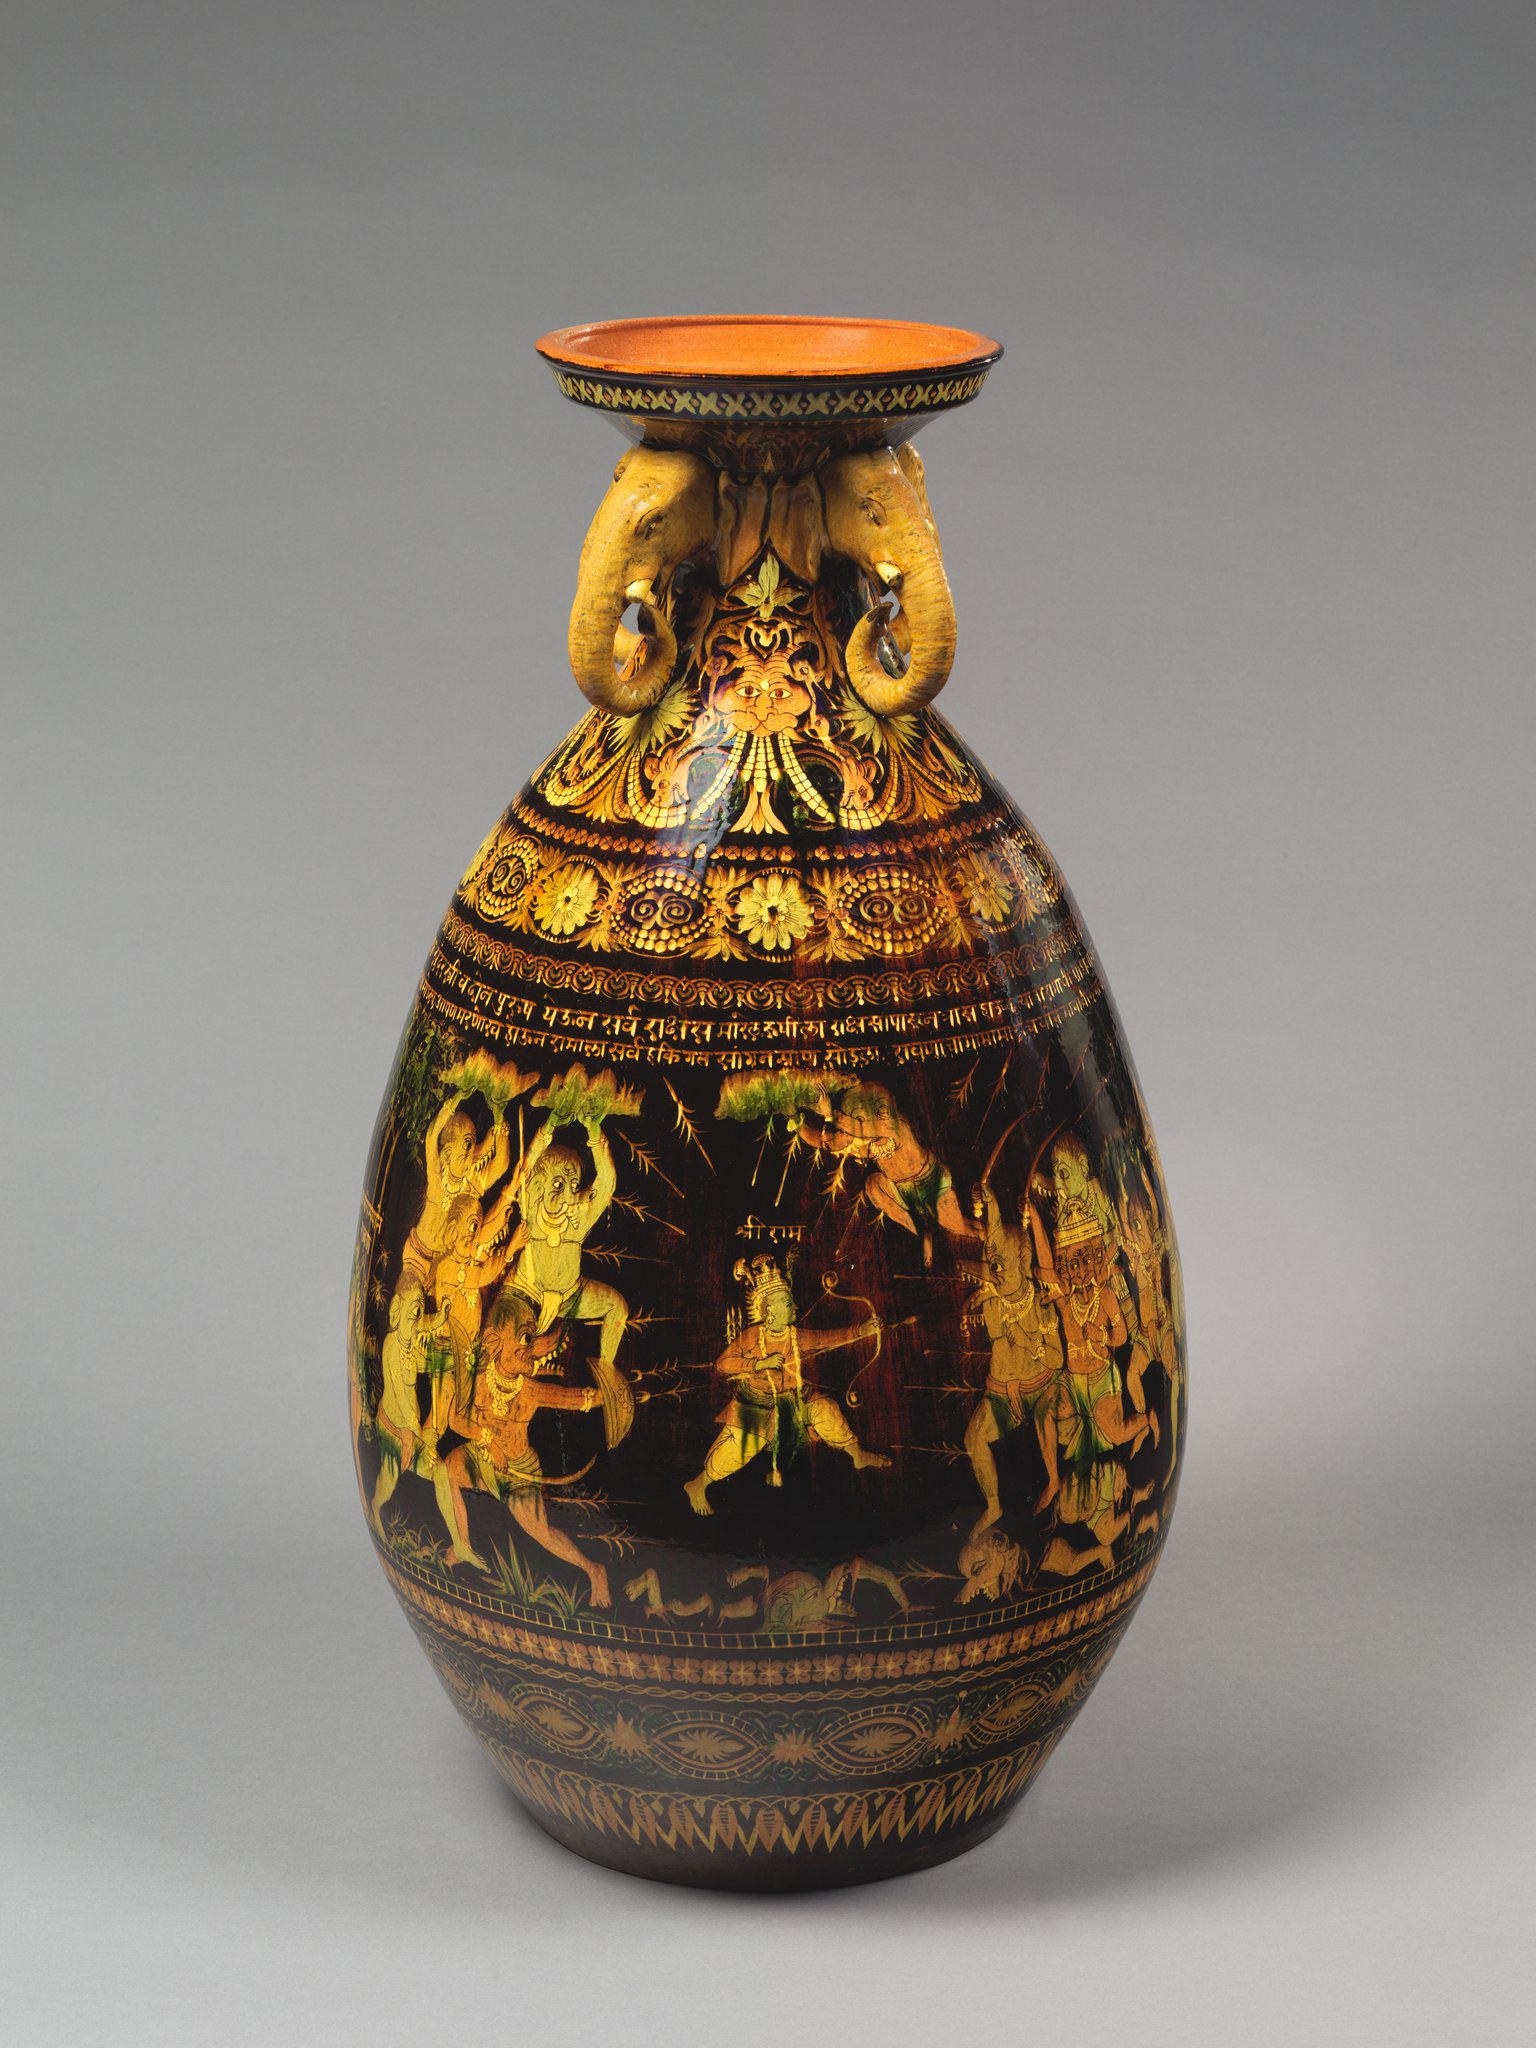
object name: vase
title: Exhibition Vase with Scenes from the Ramayana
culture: indian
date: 1880-1889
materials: earthenware, glaze